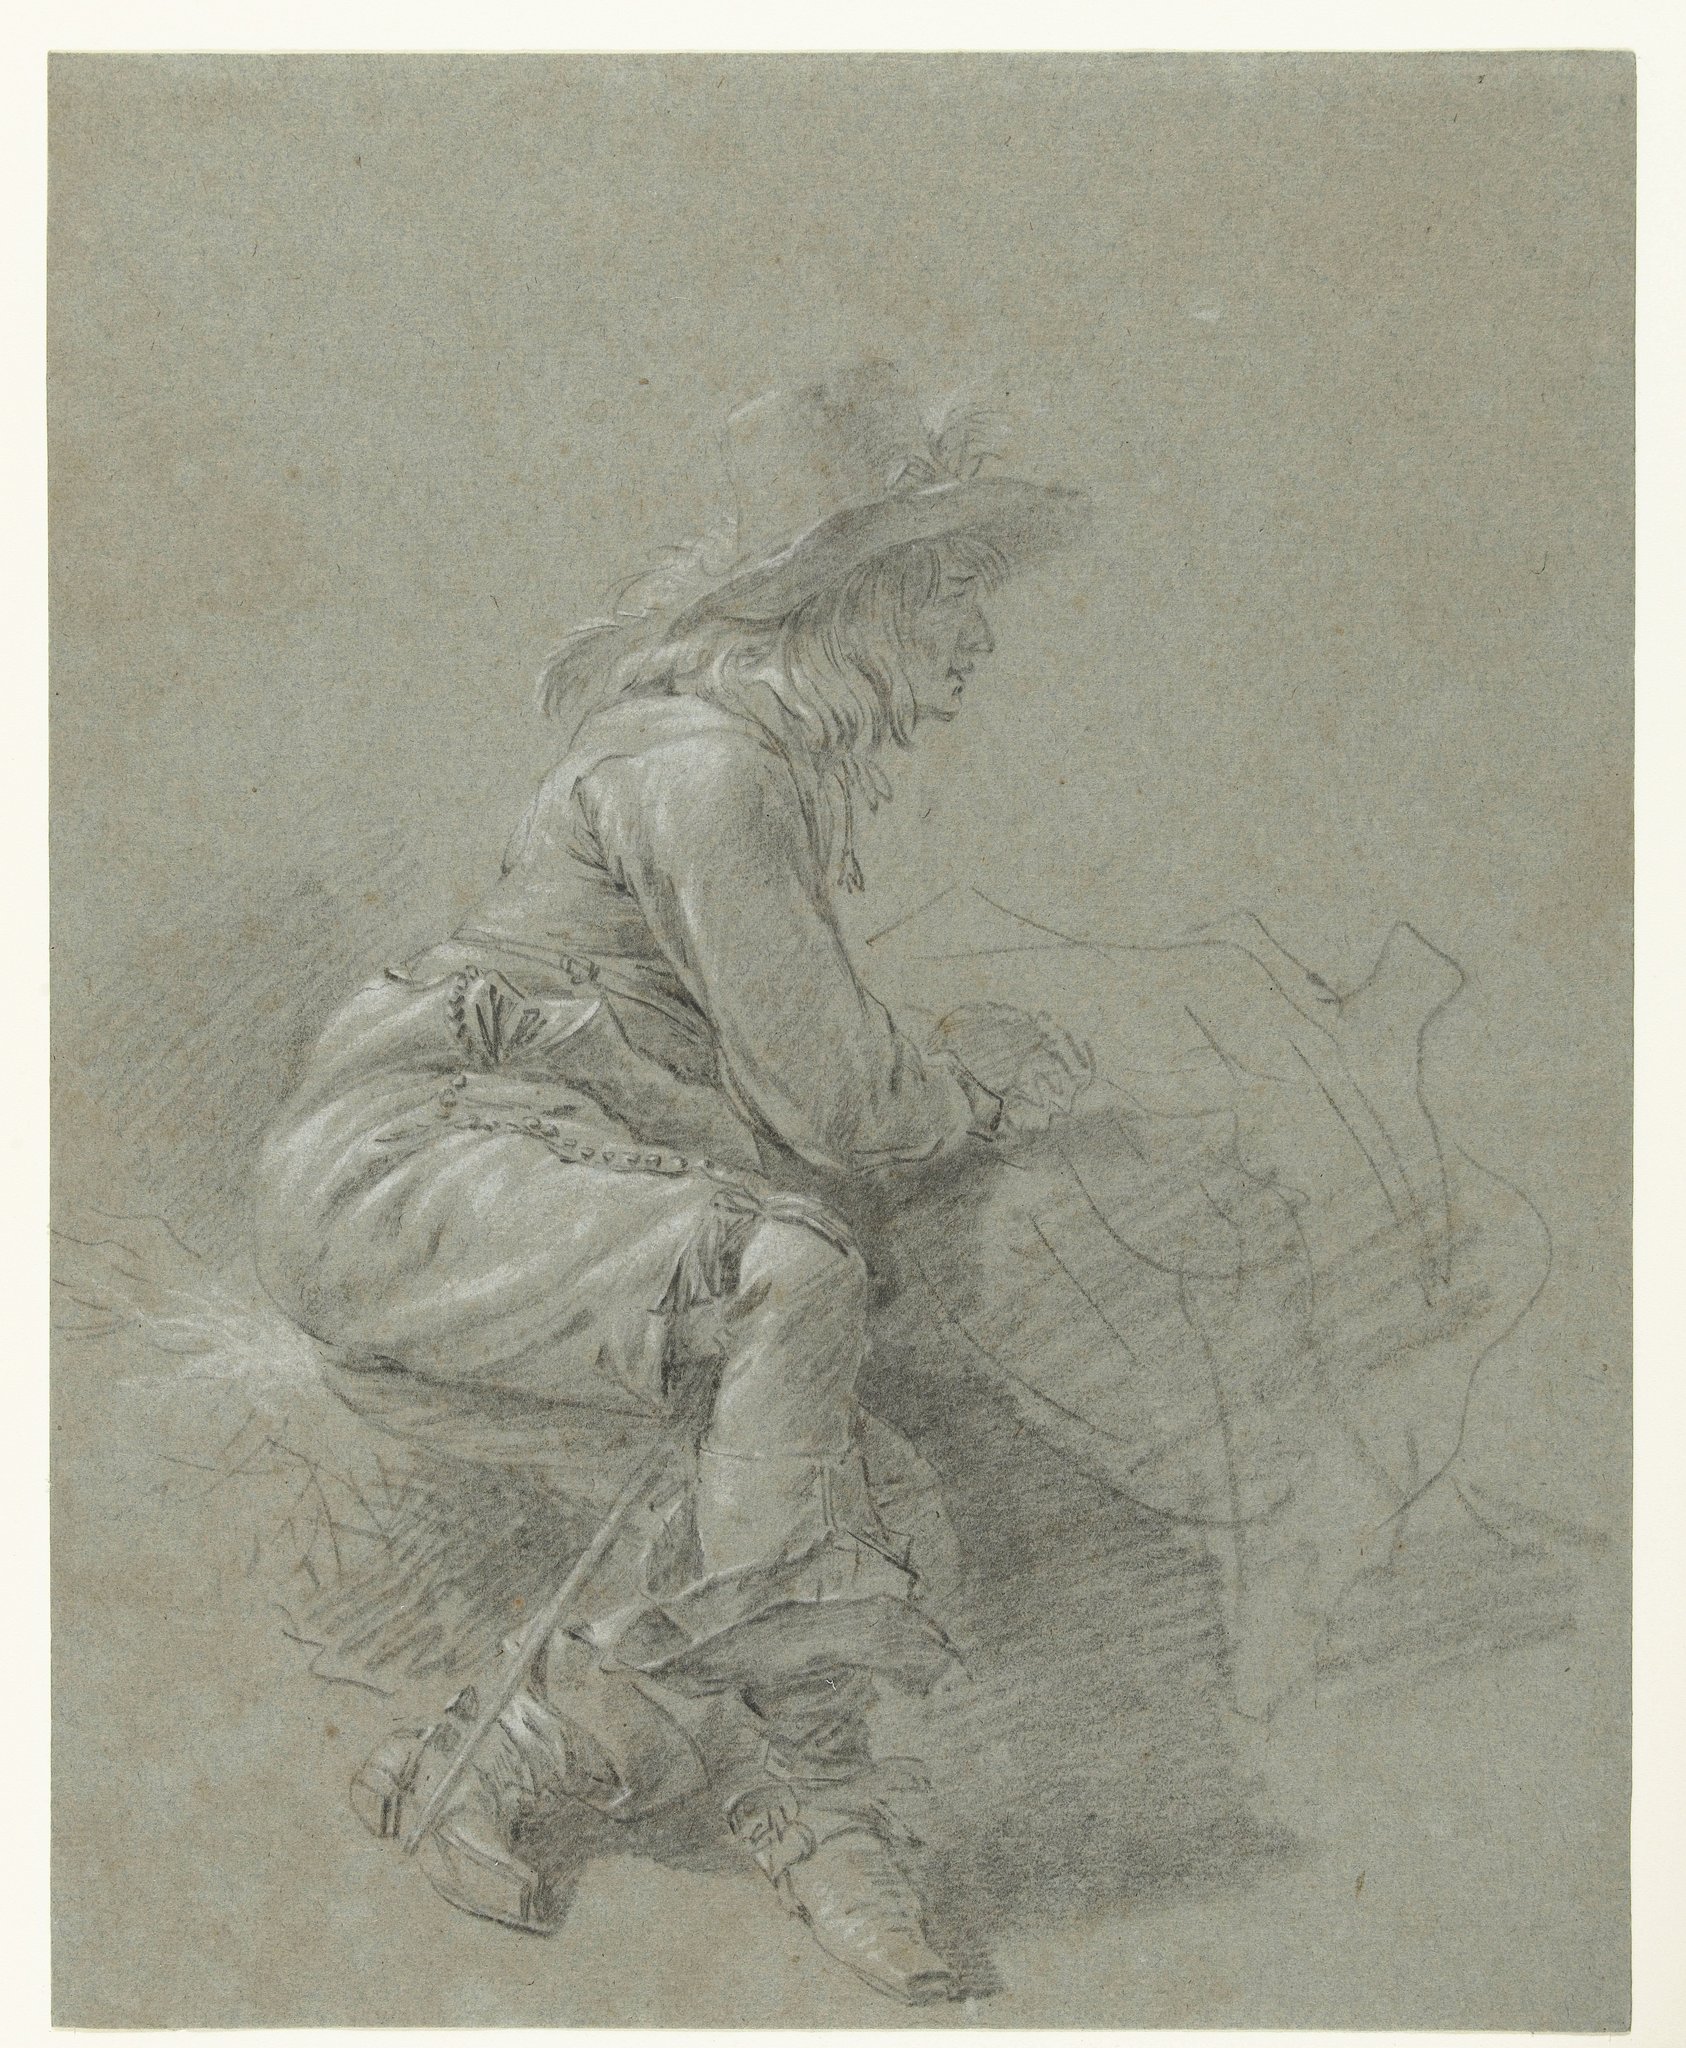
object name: drawing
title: Sitting Horseman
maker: nicolaes pietersz berchem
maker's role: draughtsman, print maker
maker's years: 1620-1683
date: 1630-1683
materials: chalk, paper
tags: sitting figure, officer